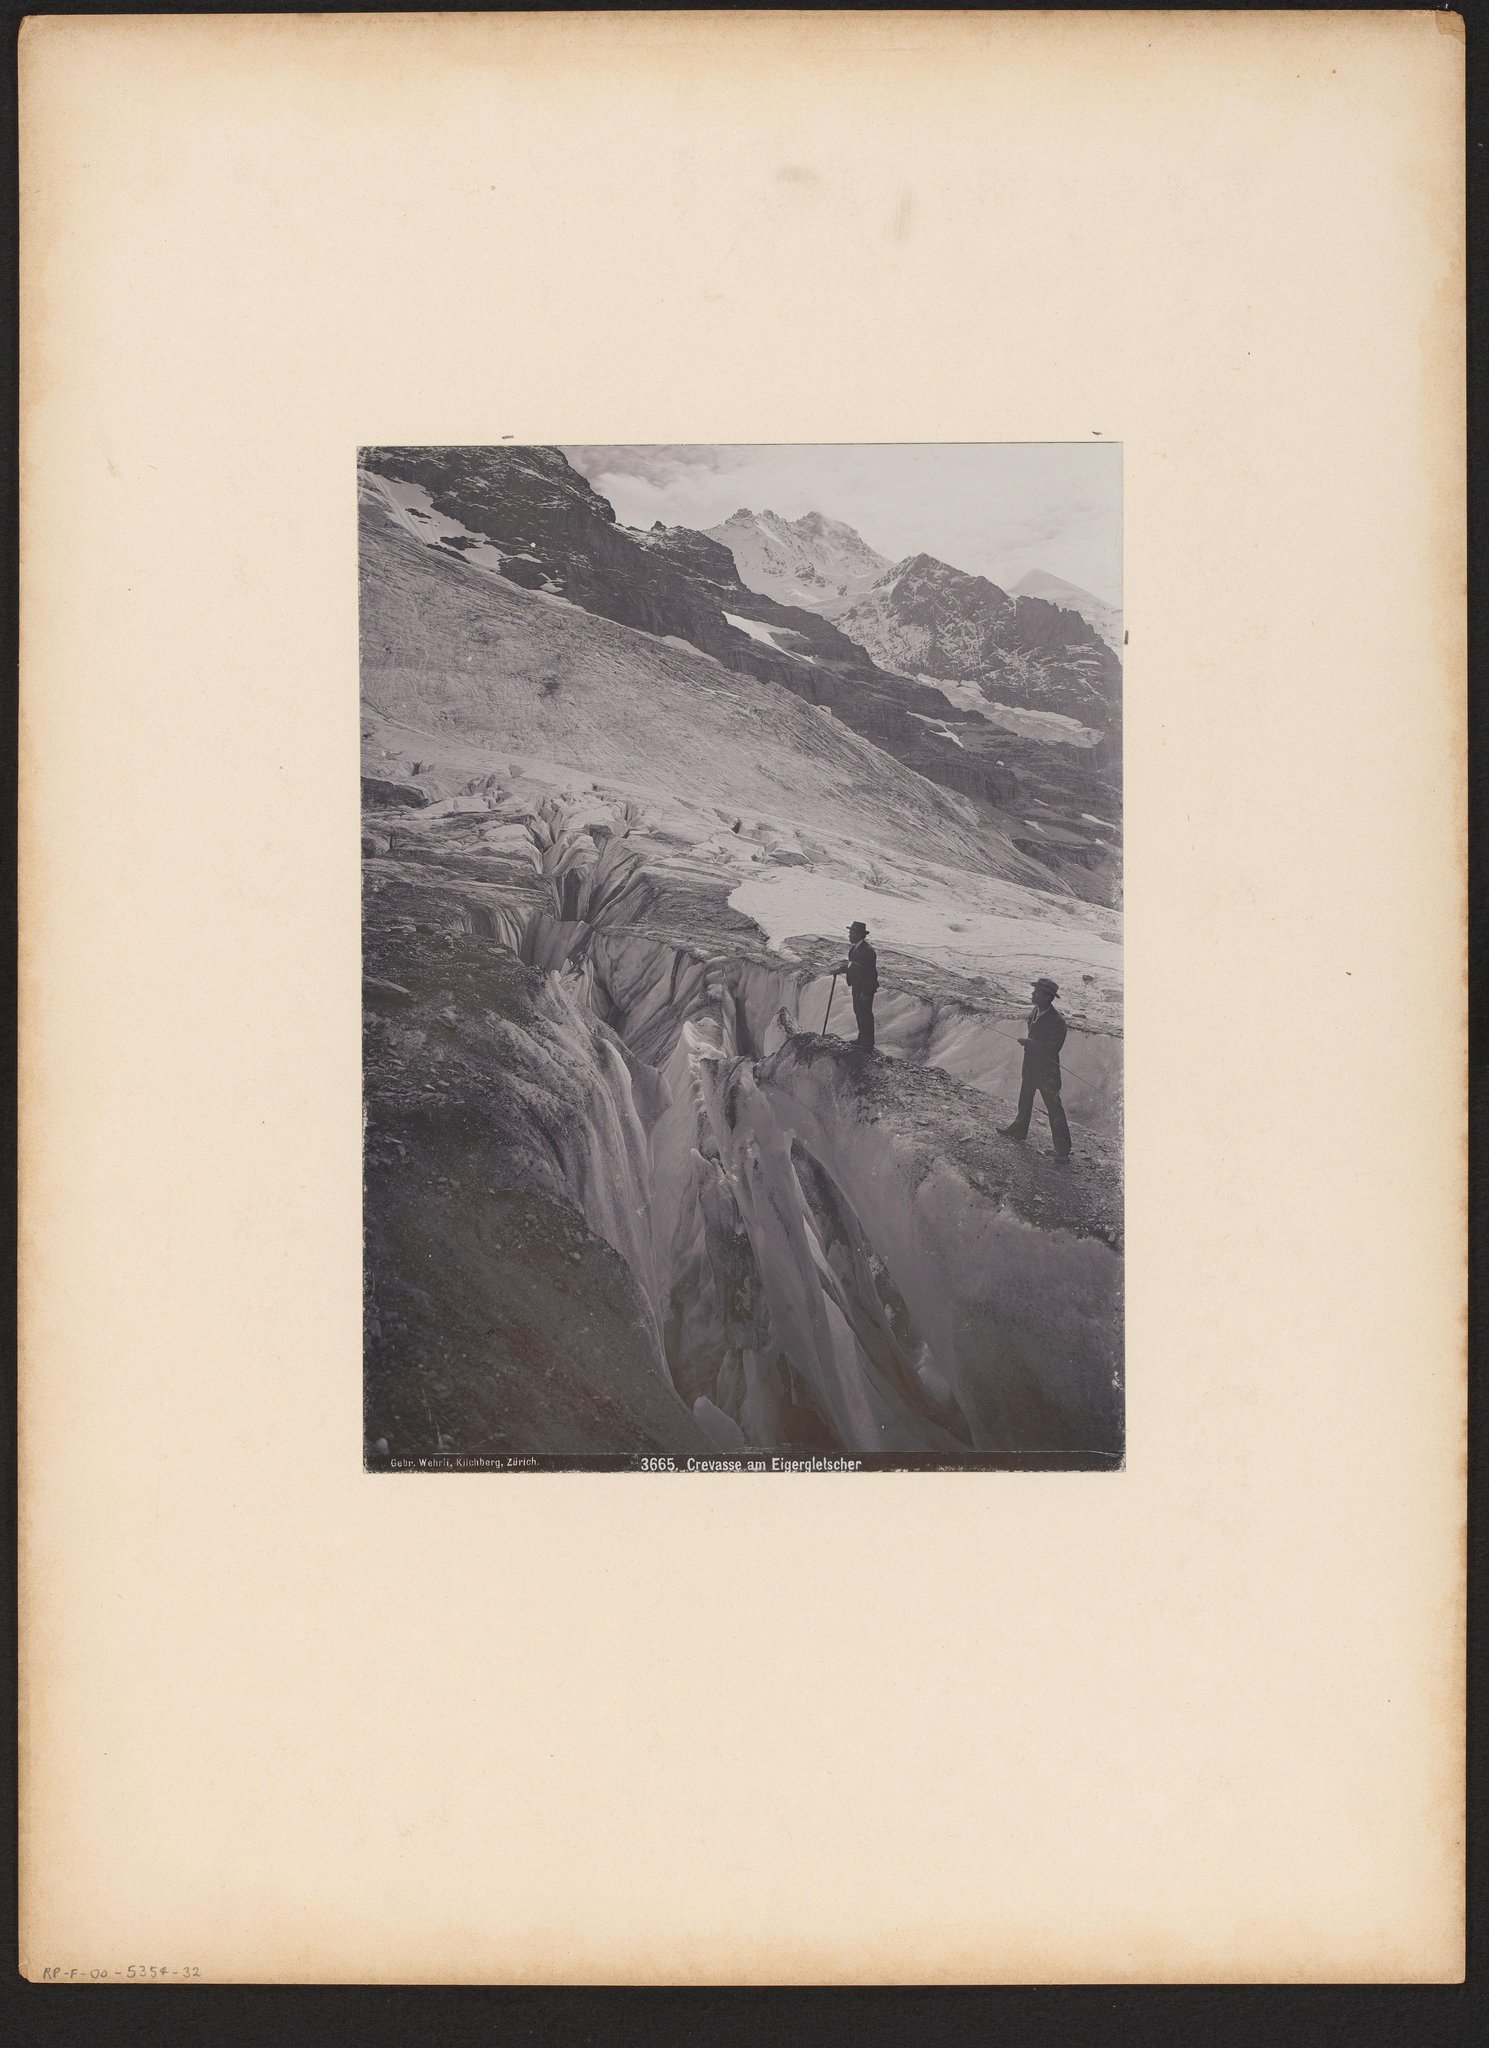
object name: photograph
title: Crevasse am Eigergletscher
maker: Anonymous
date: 1897-1920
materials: paper, cardboard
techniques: collodion silver print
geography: eiger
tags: mountain climbing, mountaineering, ravine, chasm, abyss, canyon, glacier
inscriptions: inscription: ‘Gebr. Wehrli, Kilchberg, Zürich. 3665. Crevasse am Eigergletscher’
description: Deze foto maakt deel uit van een omslag.